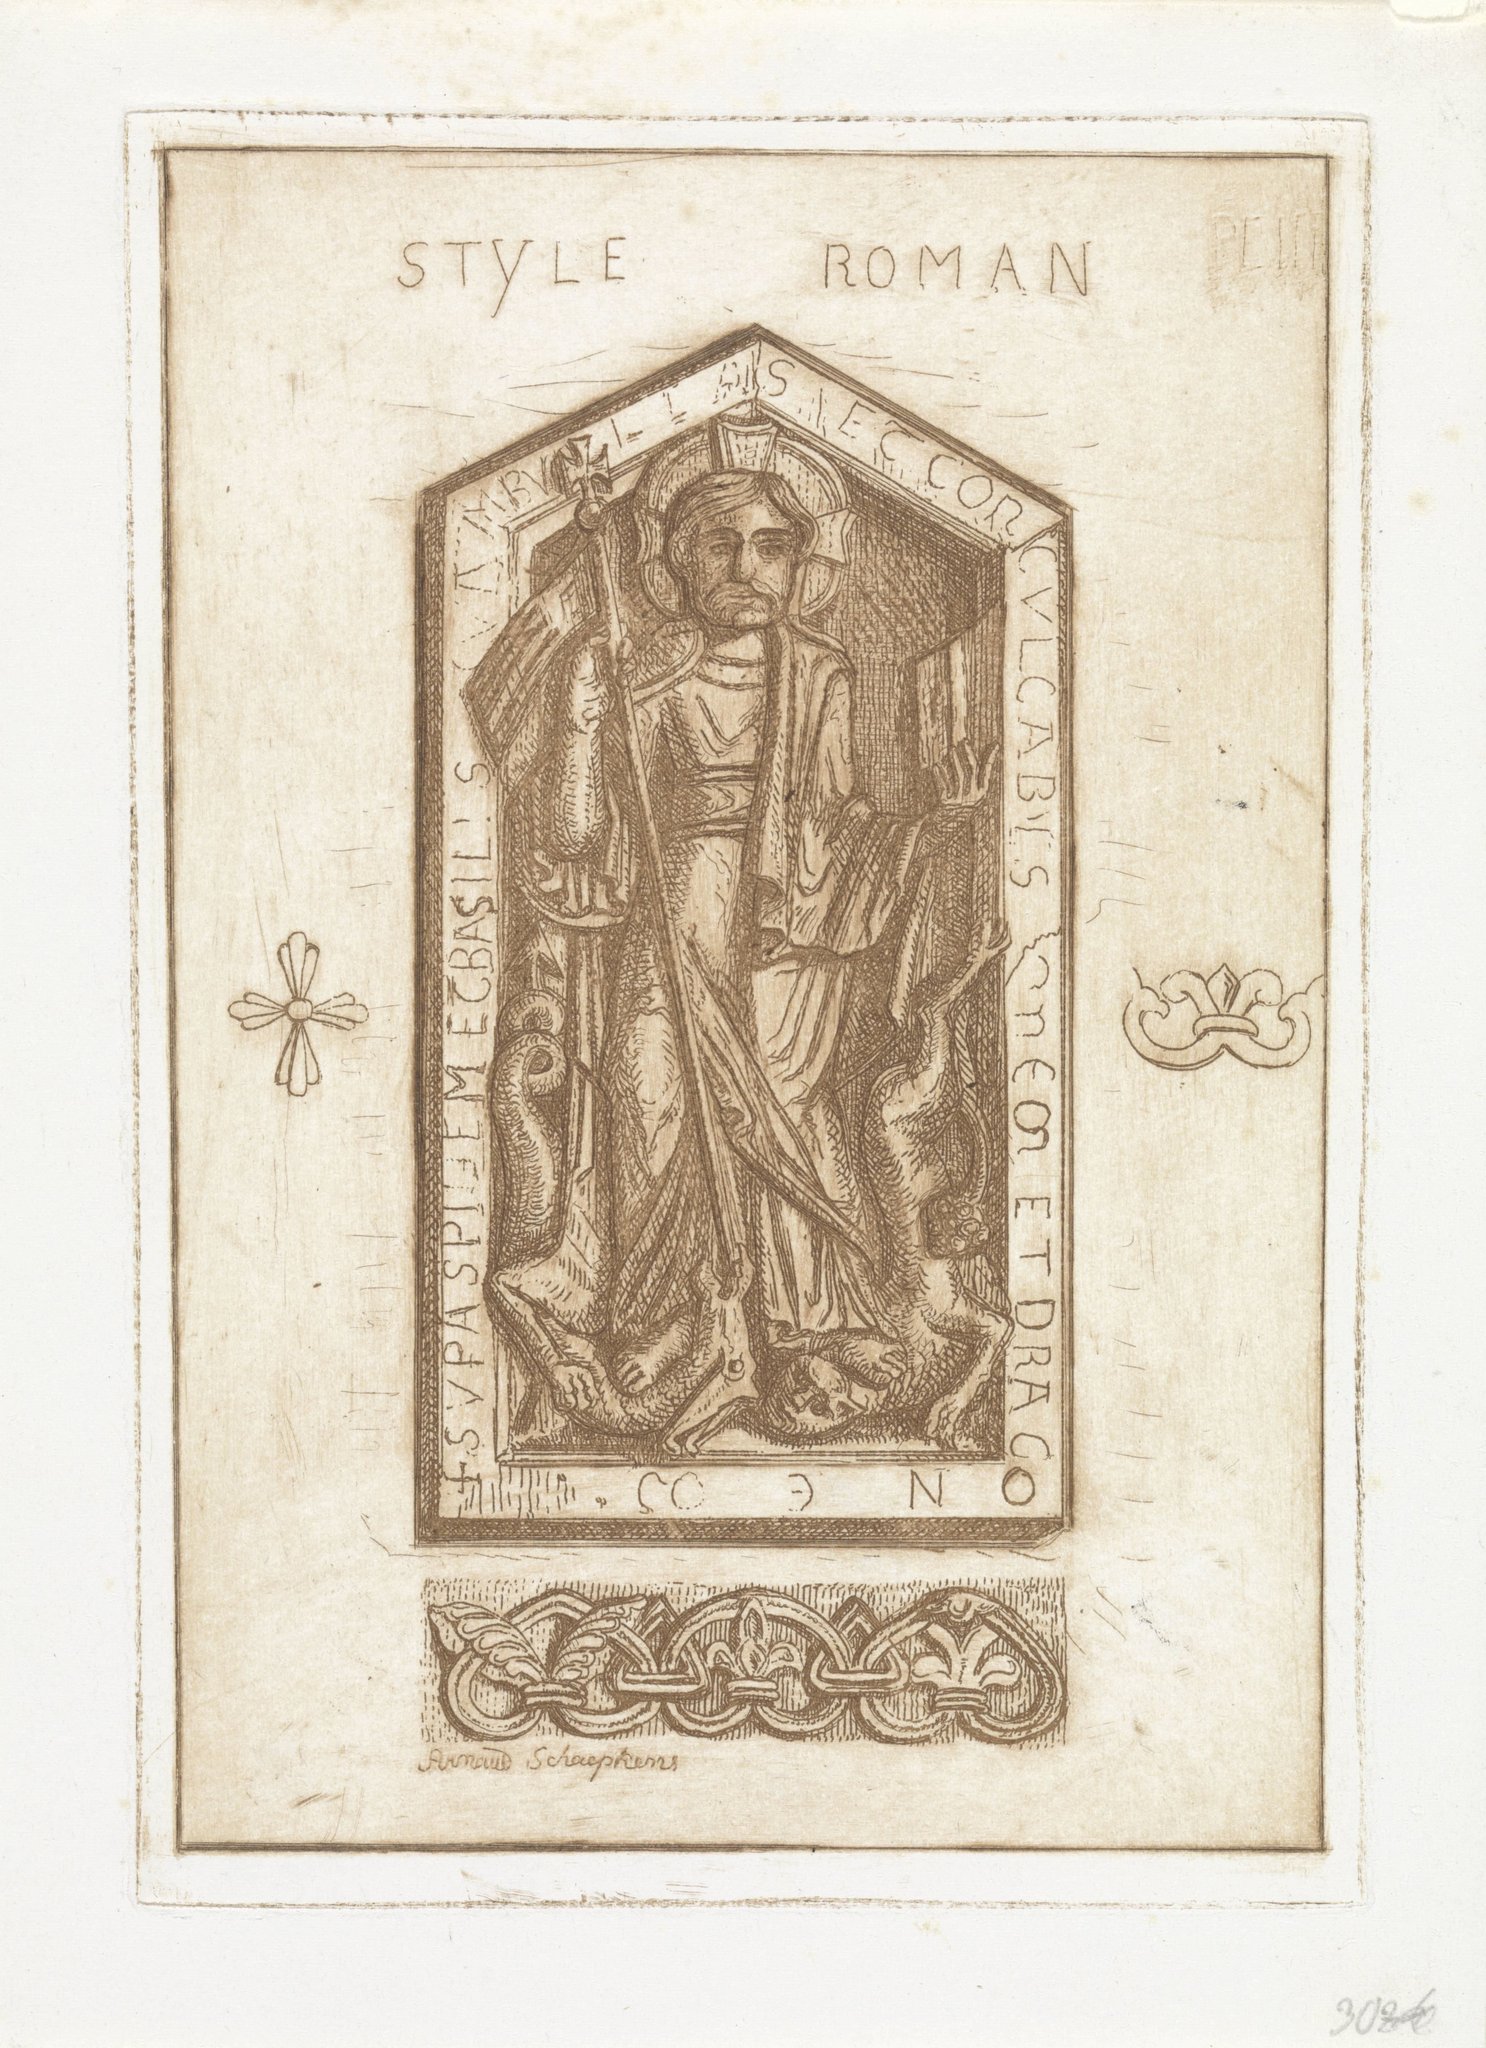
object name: print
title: Style Romain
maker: arnoud schaepkens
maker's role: print maker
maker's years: 1816-1904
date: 1831-1904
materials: paper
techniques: etching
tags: triumphant christ, e.g. on triumphal chariot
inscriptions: collector's mark: Lugt 1485, collector's mark: Lugt 2228